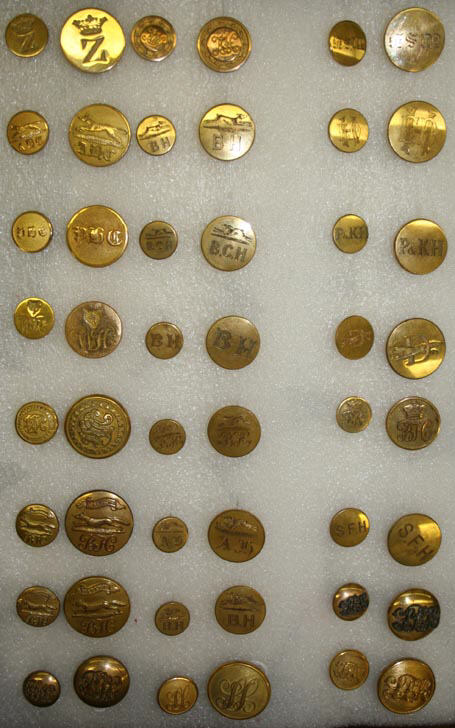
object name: button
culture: british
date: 1850-1880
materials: metal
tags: animals